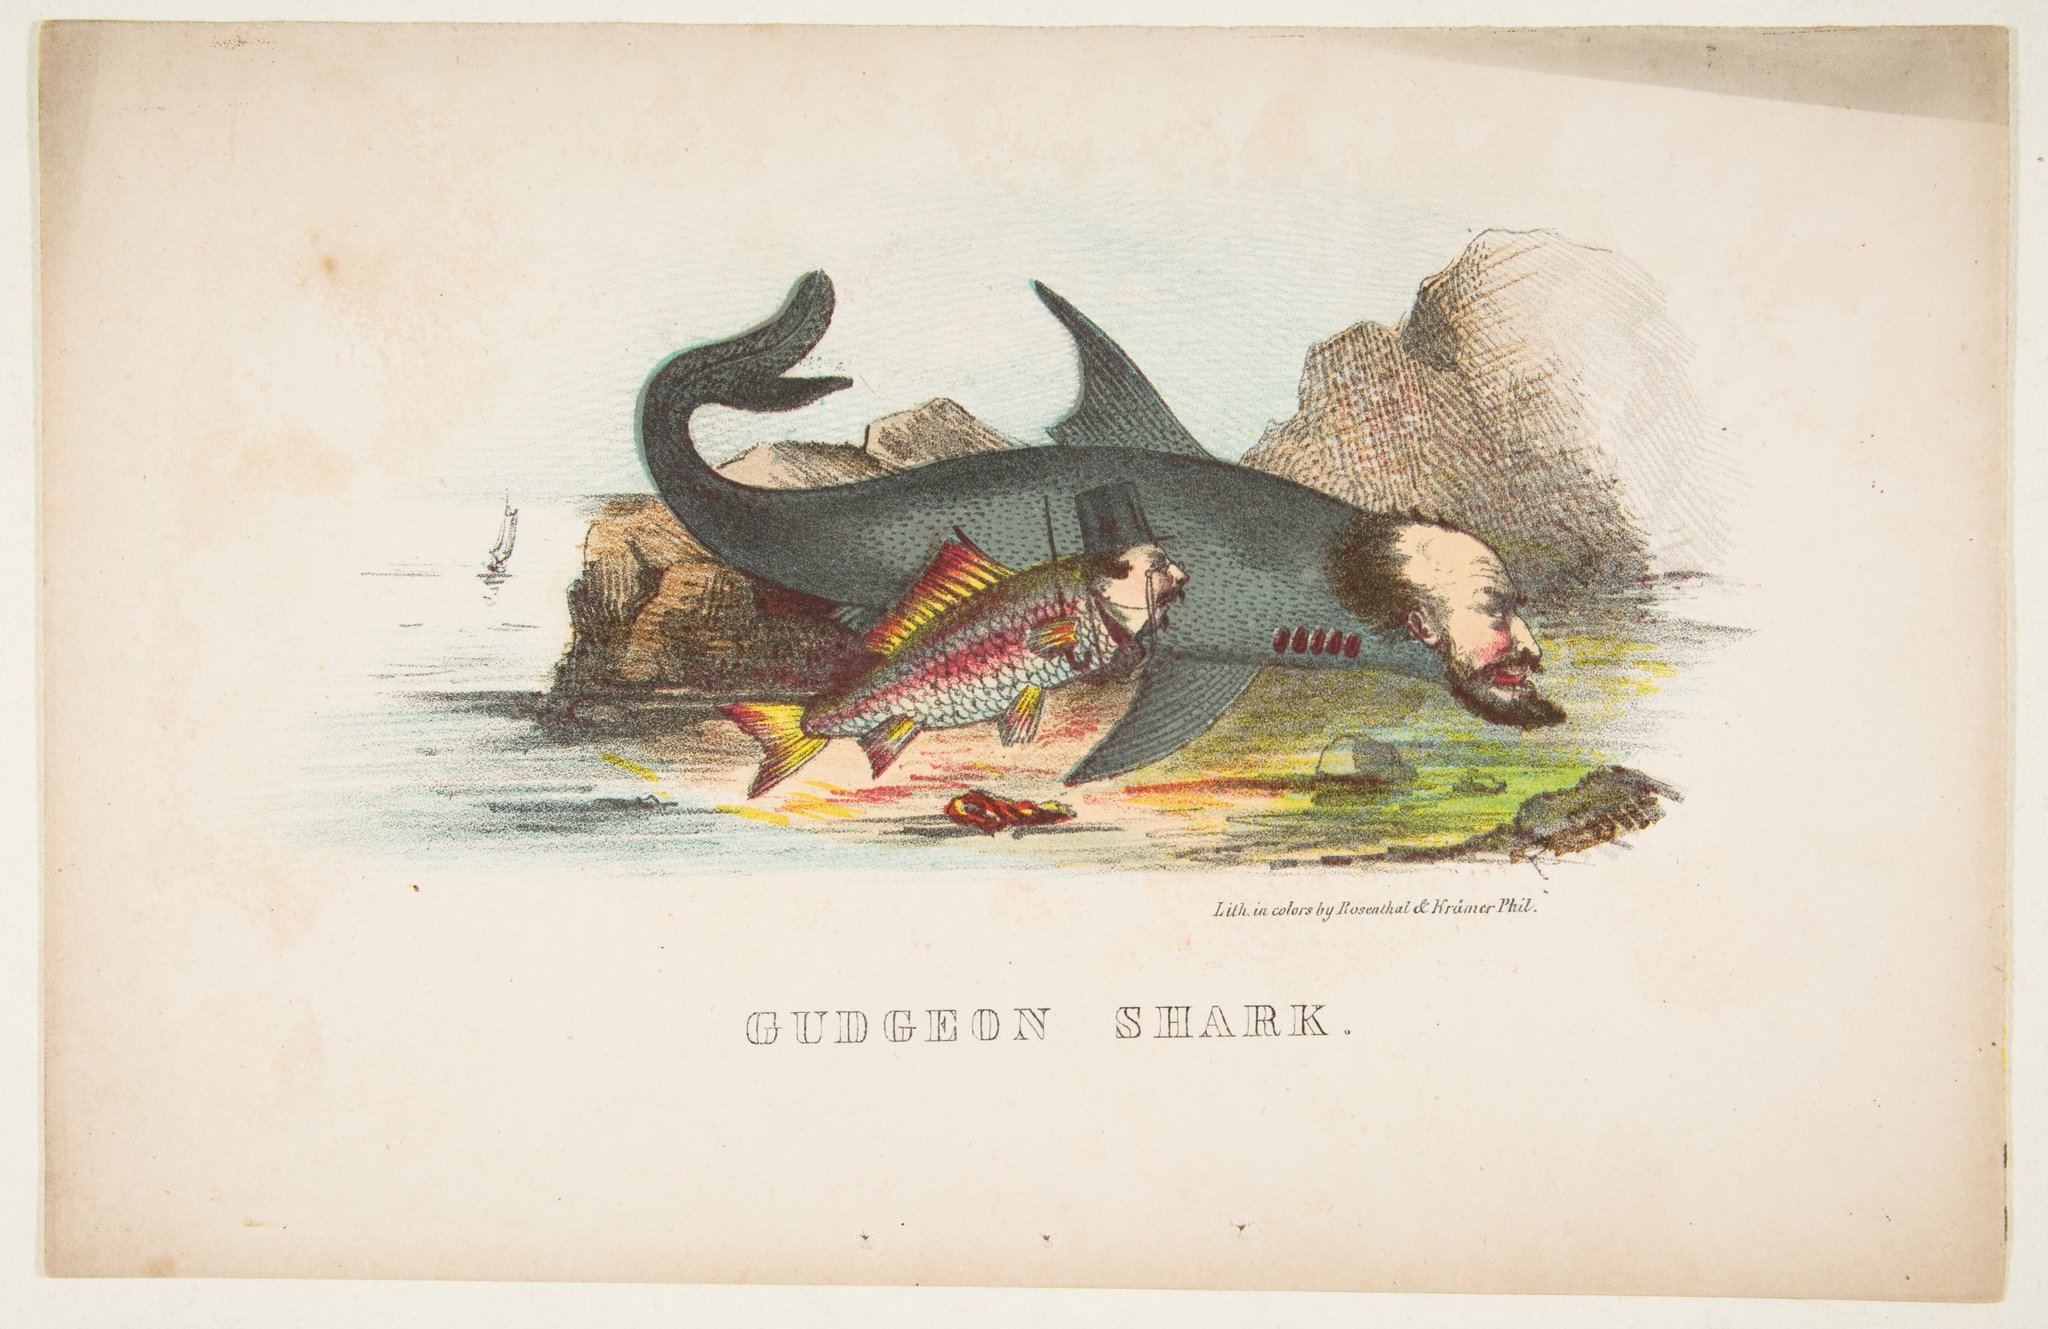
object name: print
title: Gudgeon and Shark, from "The Comic Natural History of the Human Race"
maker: henry louis stephens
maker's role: artist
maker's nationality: american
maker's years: 1824-1882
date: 1851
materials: watercolor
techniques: lithograph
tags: faces,fish